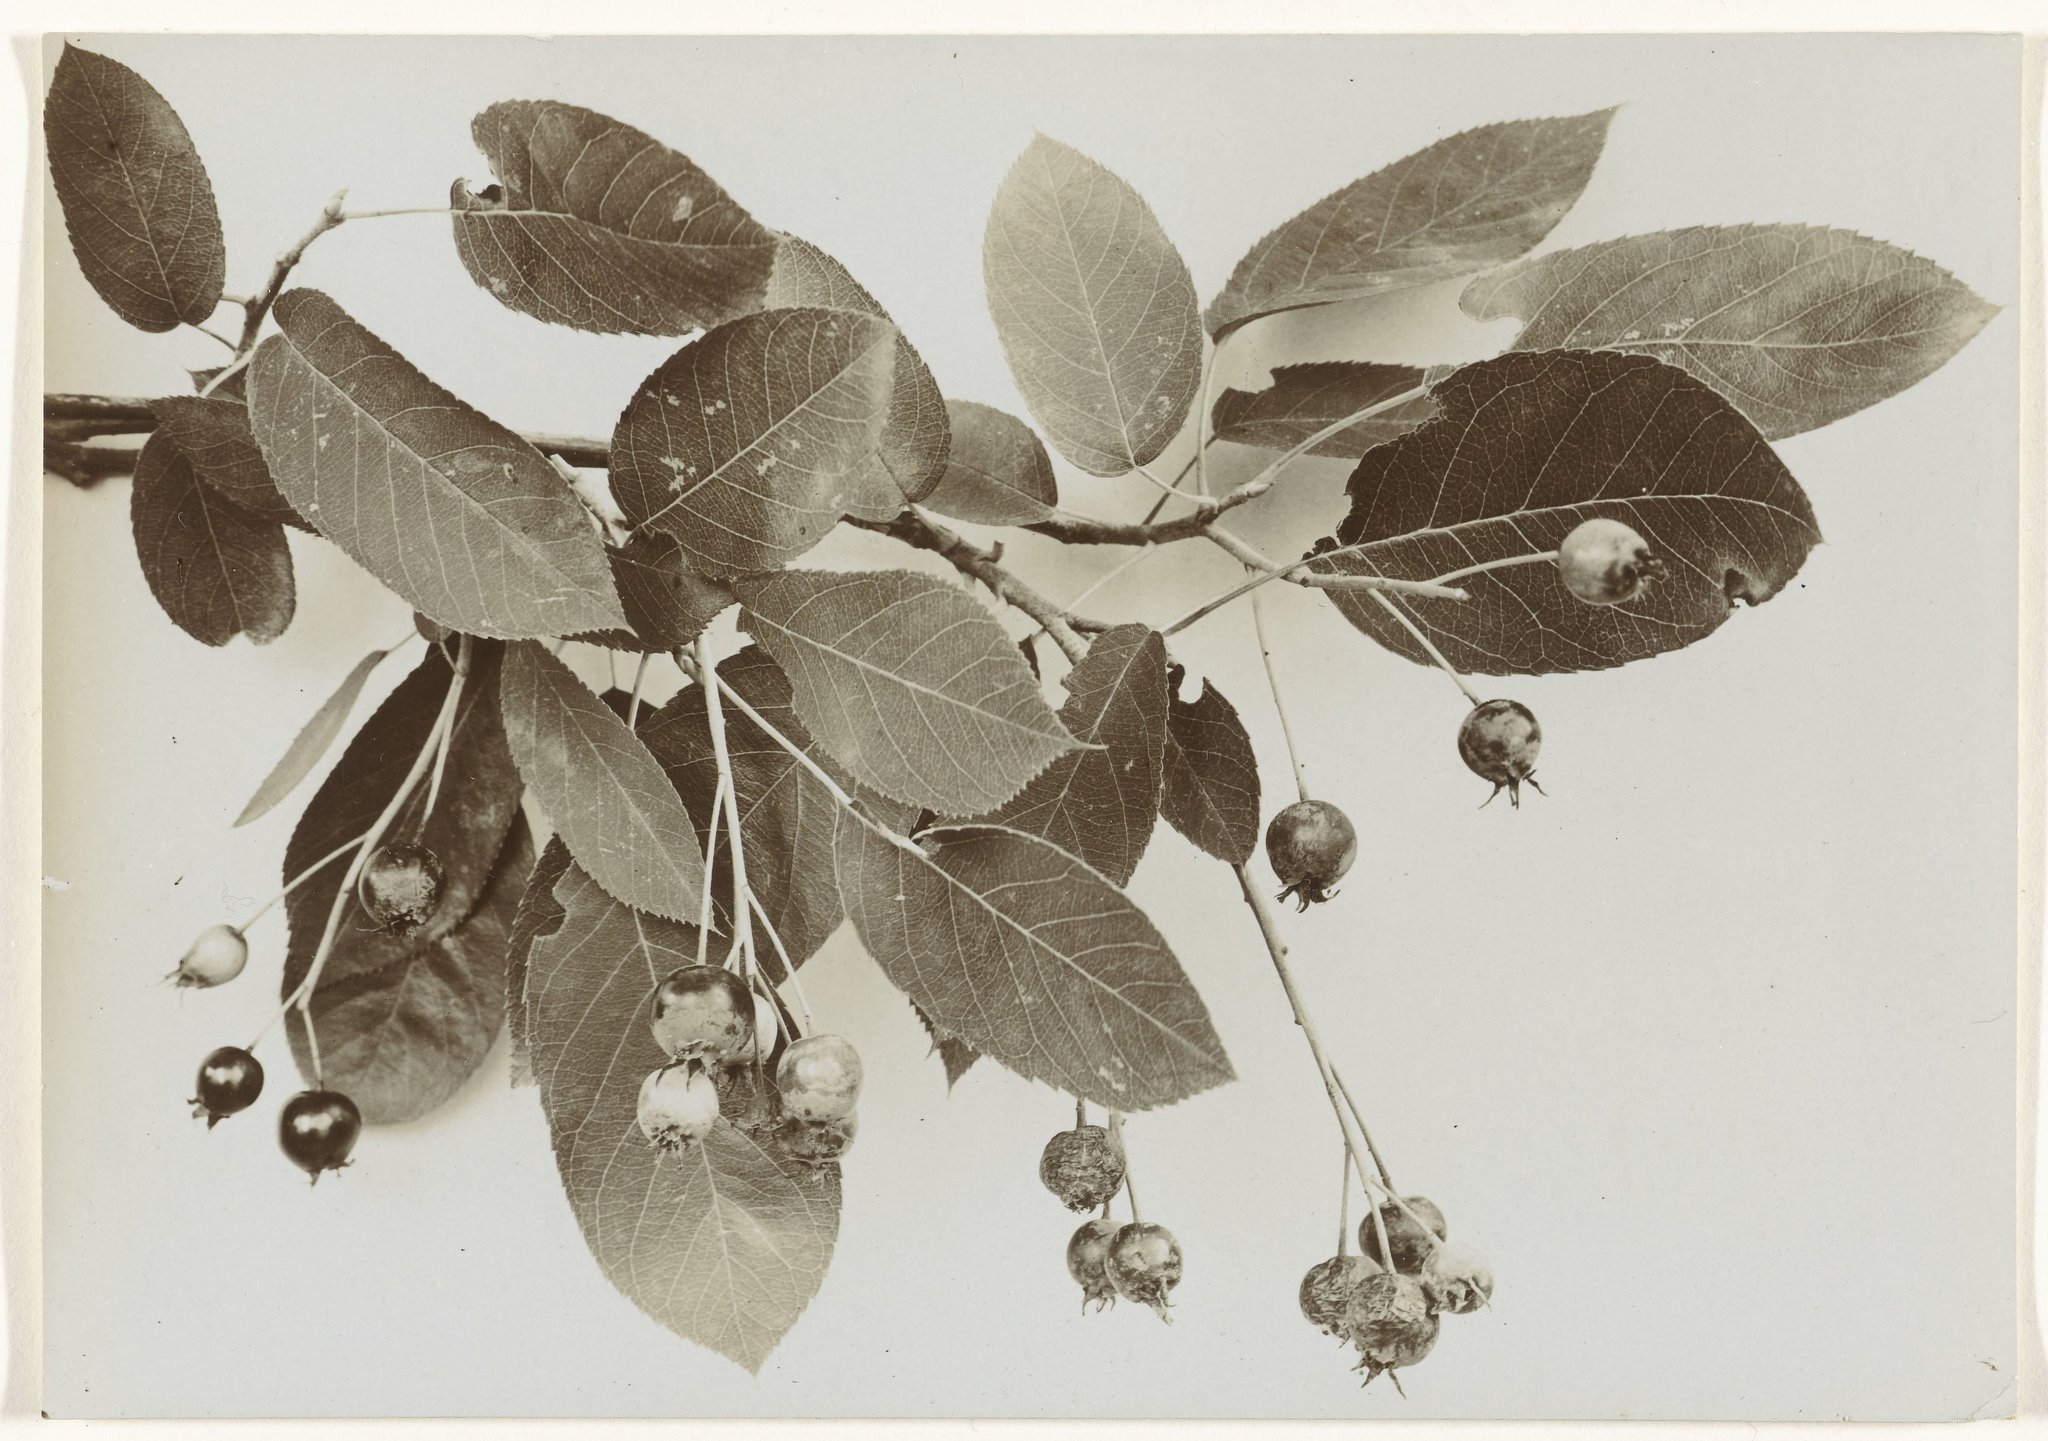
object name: photograph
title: Tak van een Canadese krentenboom met vruchten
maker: richard tepe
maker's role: fotograaf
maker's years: 1864-1952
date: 1900-1930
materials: photographic support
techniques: gelatin silver print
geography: netherlands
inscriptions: annotation: ‘Amelanchier canadensis / vruchtdragende tak’, signature: ‘foto / R. Tepe’